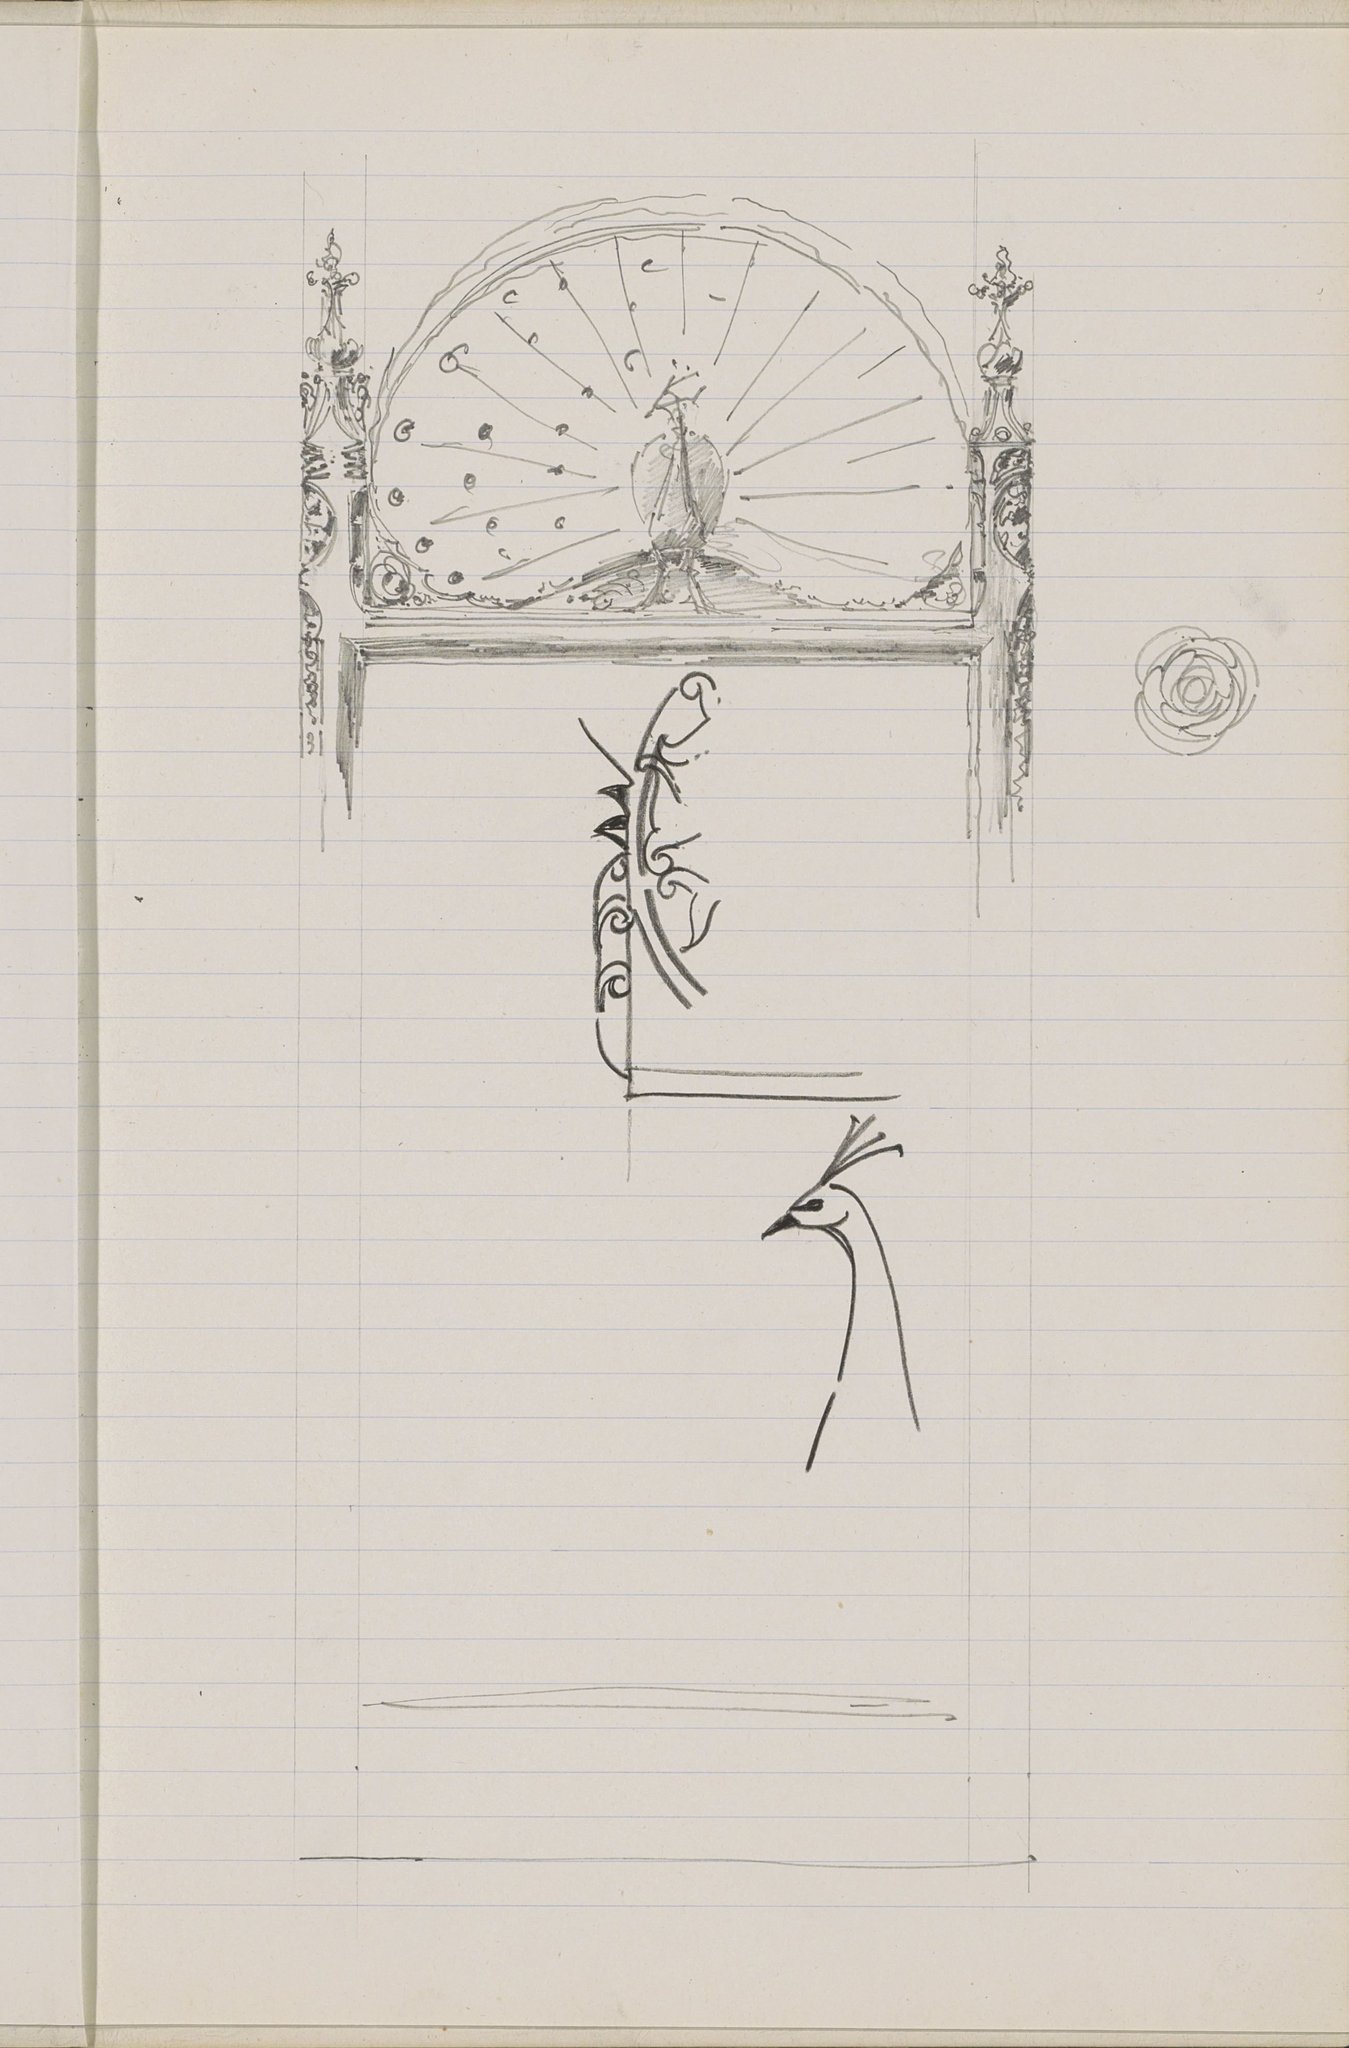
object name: sketchbook leaf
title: Meubelstuk met een ornamentele pauw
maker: gerrit willem dijsselhof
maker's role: designer, draughtsman, print maker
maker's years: 1866-1924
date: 1901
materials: chalk, pencil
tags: ornamental birds: peacock, furniture and household effects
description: Tevens studies van een sierlijst, roos en vogel met een kuif. Blad 56 recto uit een schetsboek met 79 bladen.